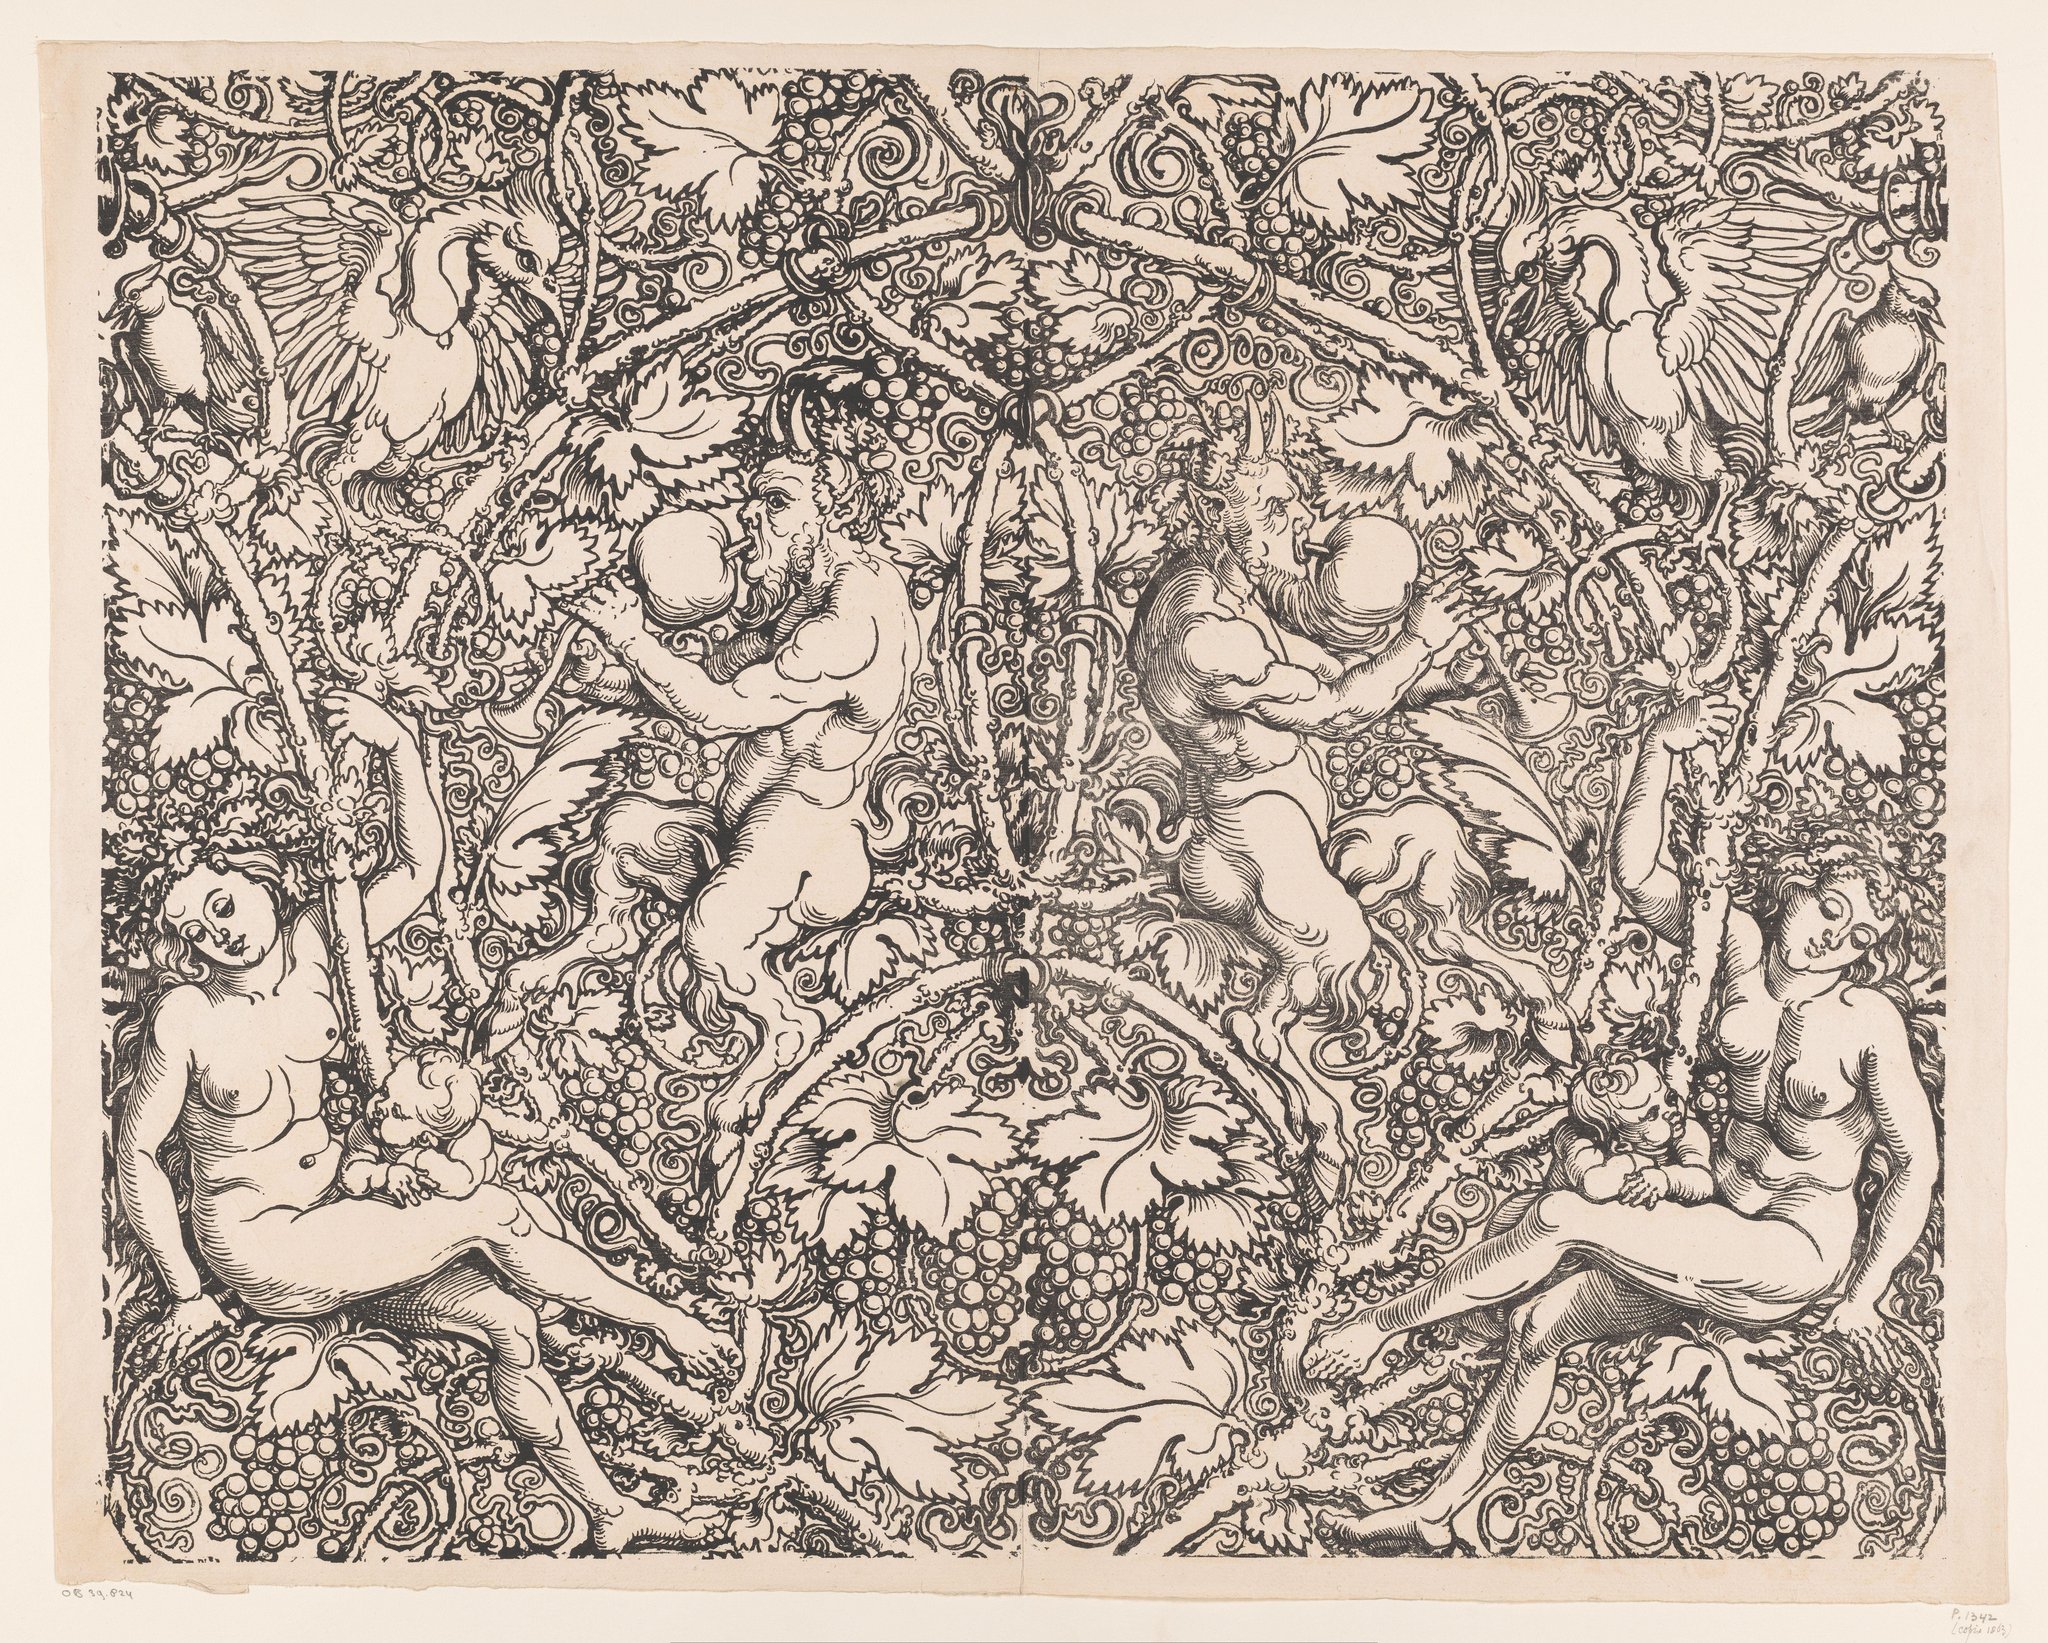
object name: print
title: Satyrfamilie tussen wijnranken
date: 1510-1550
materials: paper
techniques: woodcut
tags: attributes of bacchus: vine, satyr(s) (in general), tapestry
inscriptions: collector's mark: Lugt 2228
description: Ontwerp voor wandtapijt bestaande uit twee gespiegelde, maar niet identieke, delen. Deze zijn hier aan elkaar geplakt.